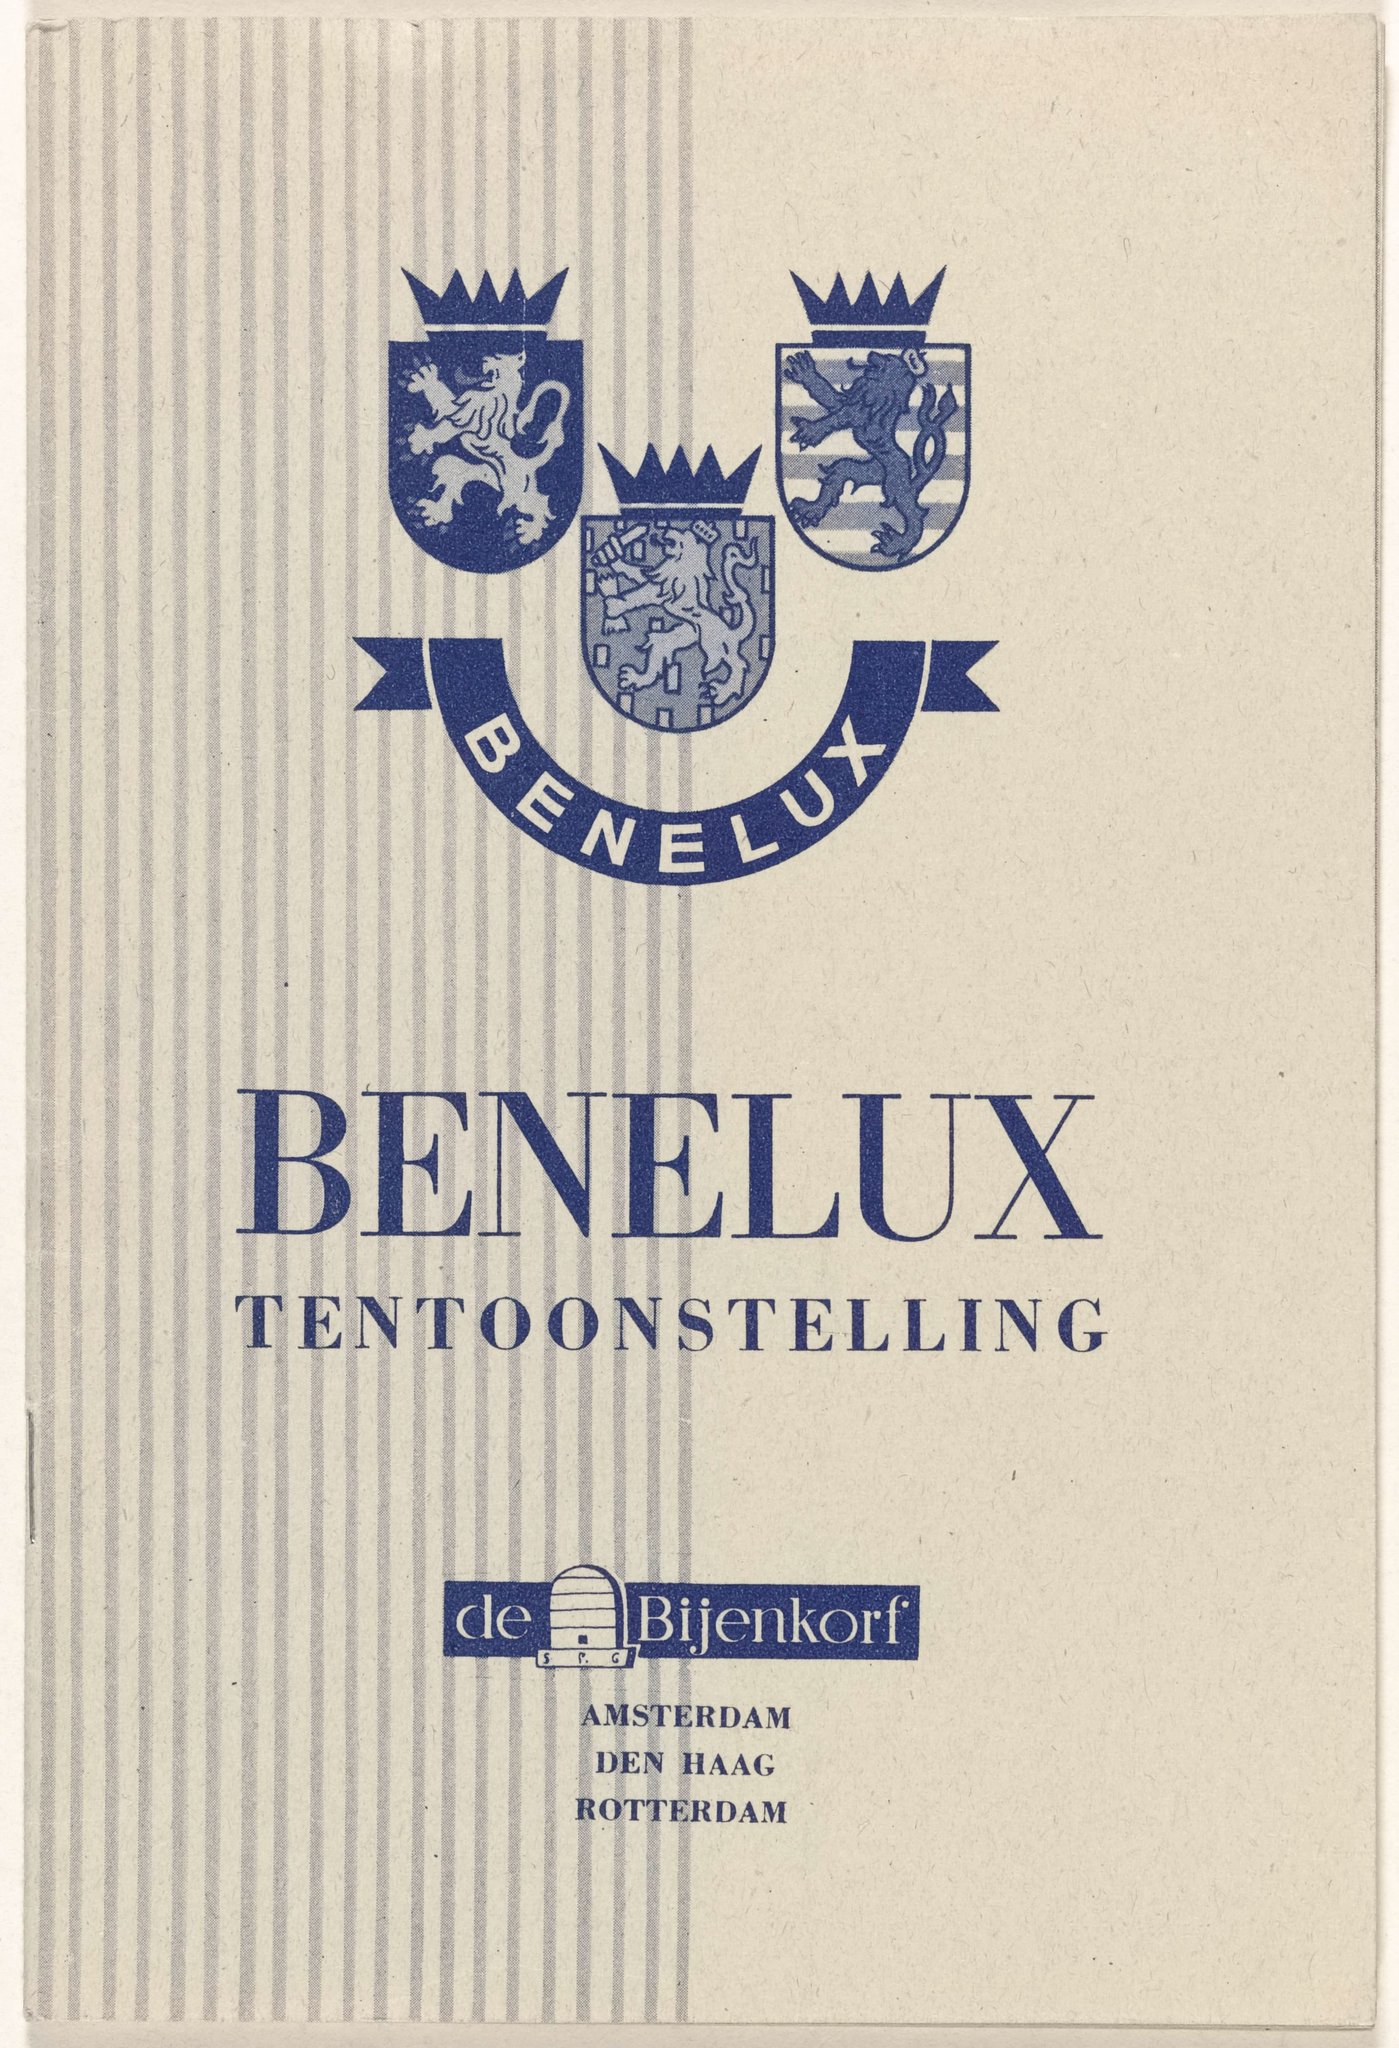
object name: brochure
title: Beneluxtentoonstelling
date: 1948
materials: paper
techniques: printing, stapling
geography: amsterdam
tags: benelux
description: Brochure, 12 genummerde pp in blauw-grijze omslag, druk in blauw, met illustraties en los vouwblad 'Wegwijzer voor de Beneluxtentoonstelling in de Bijenkorf'.